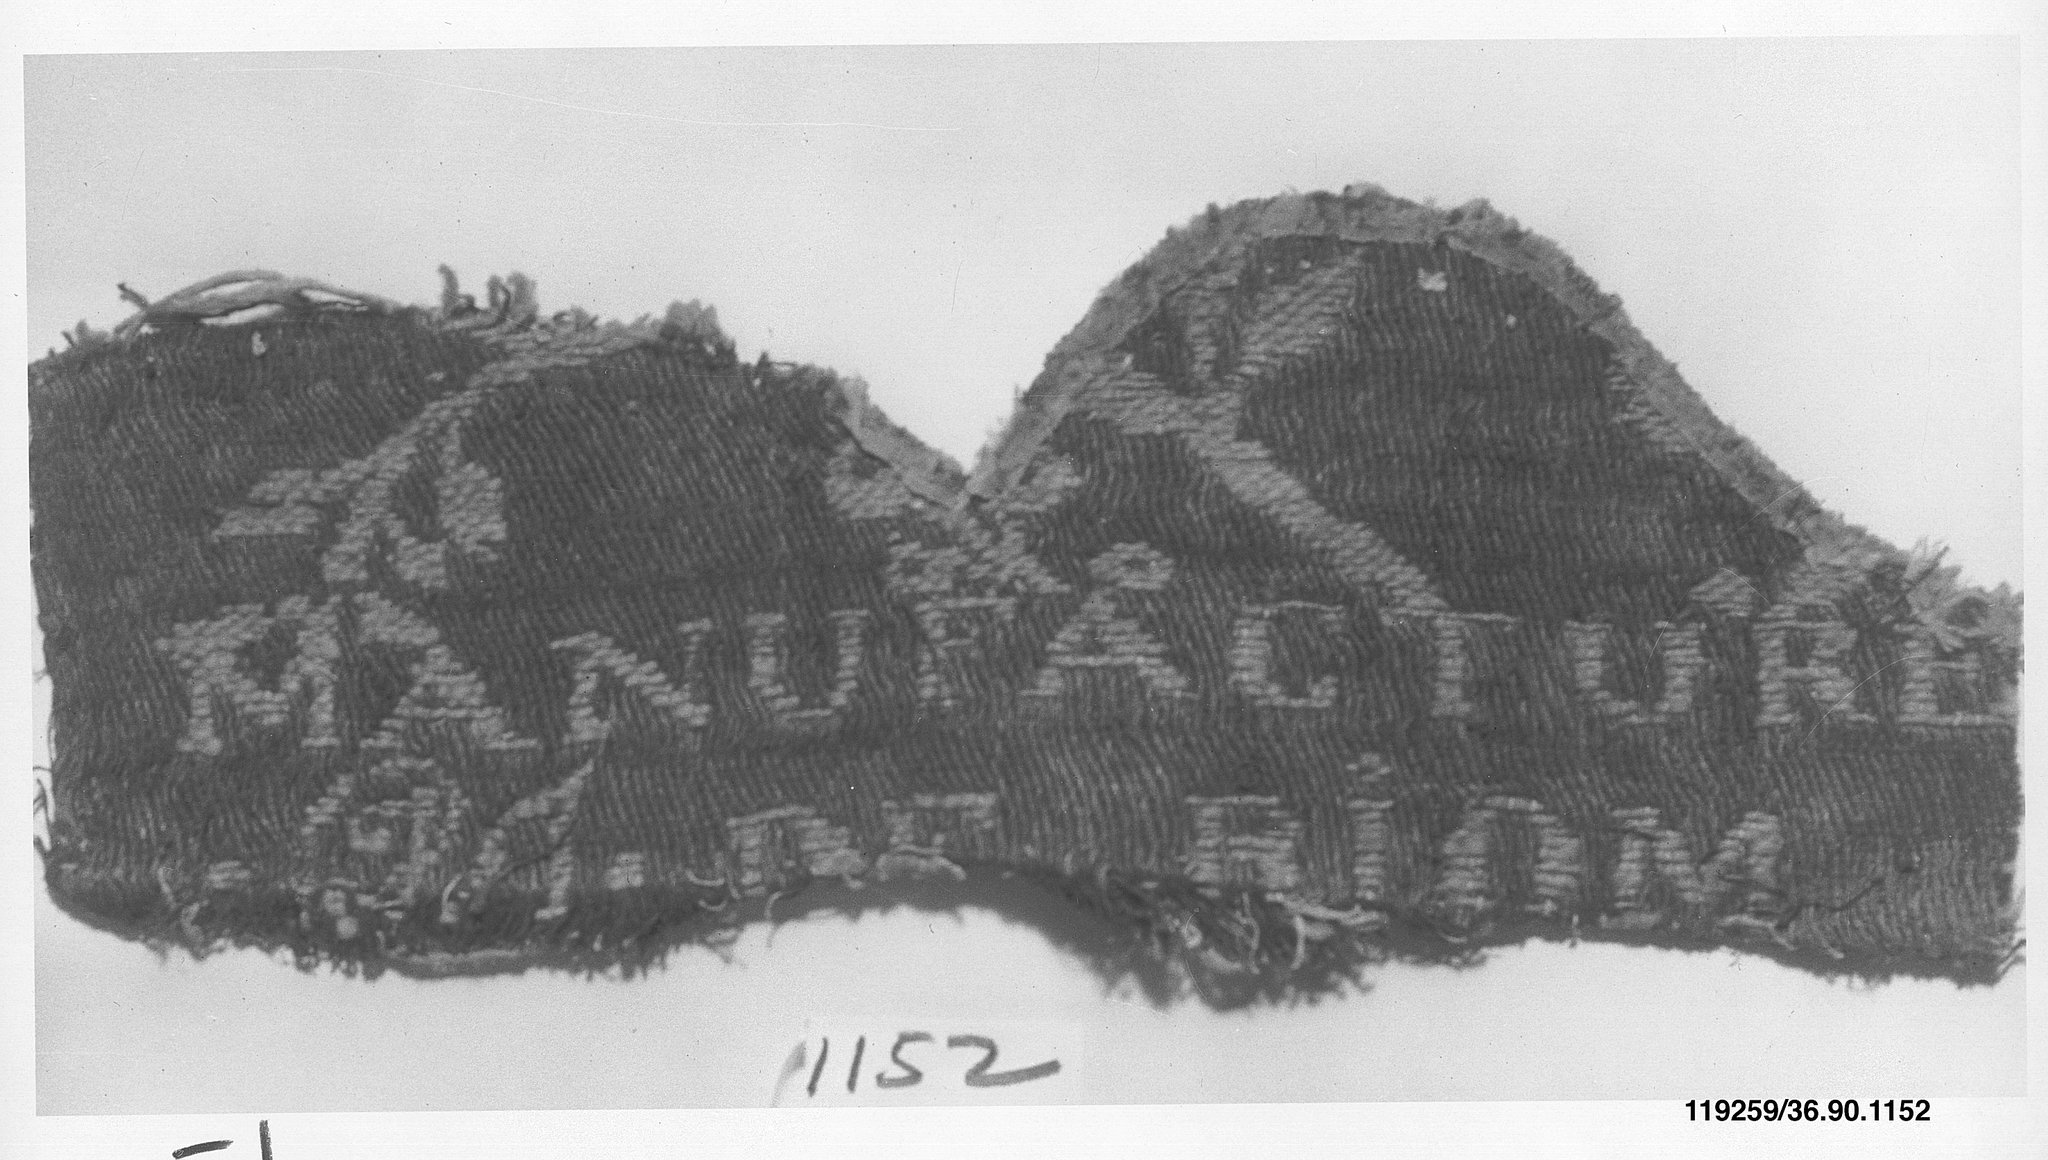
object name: piece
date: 1701-1800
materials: cotton